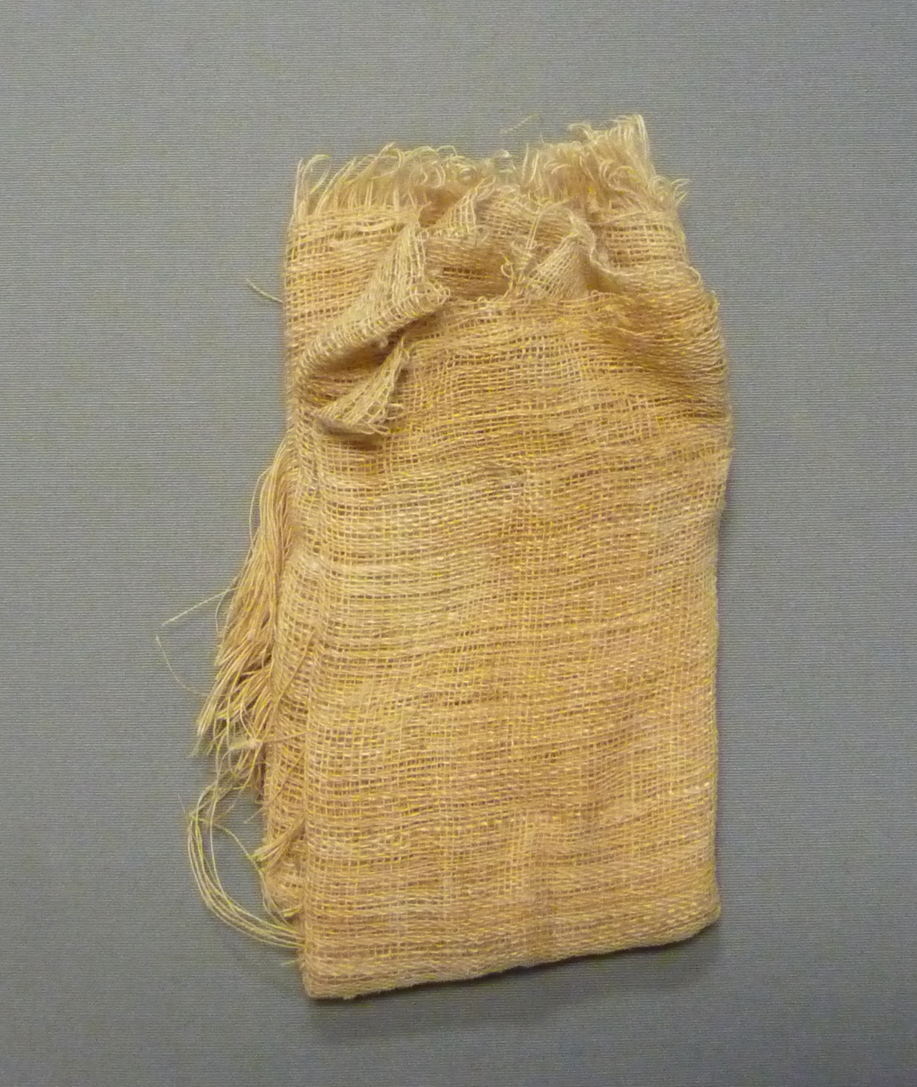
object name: linen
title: Model Sheet from a Foundation Deposit for Hatshepsut's Temple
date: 1479-1458 BCE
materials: linen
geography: egypt